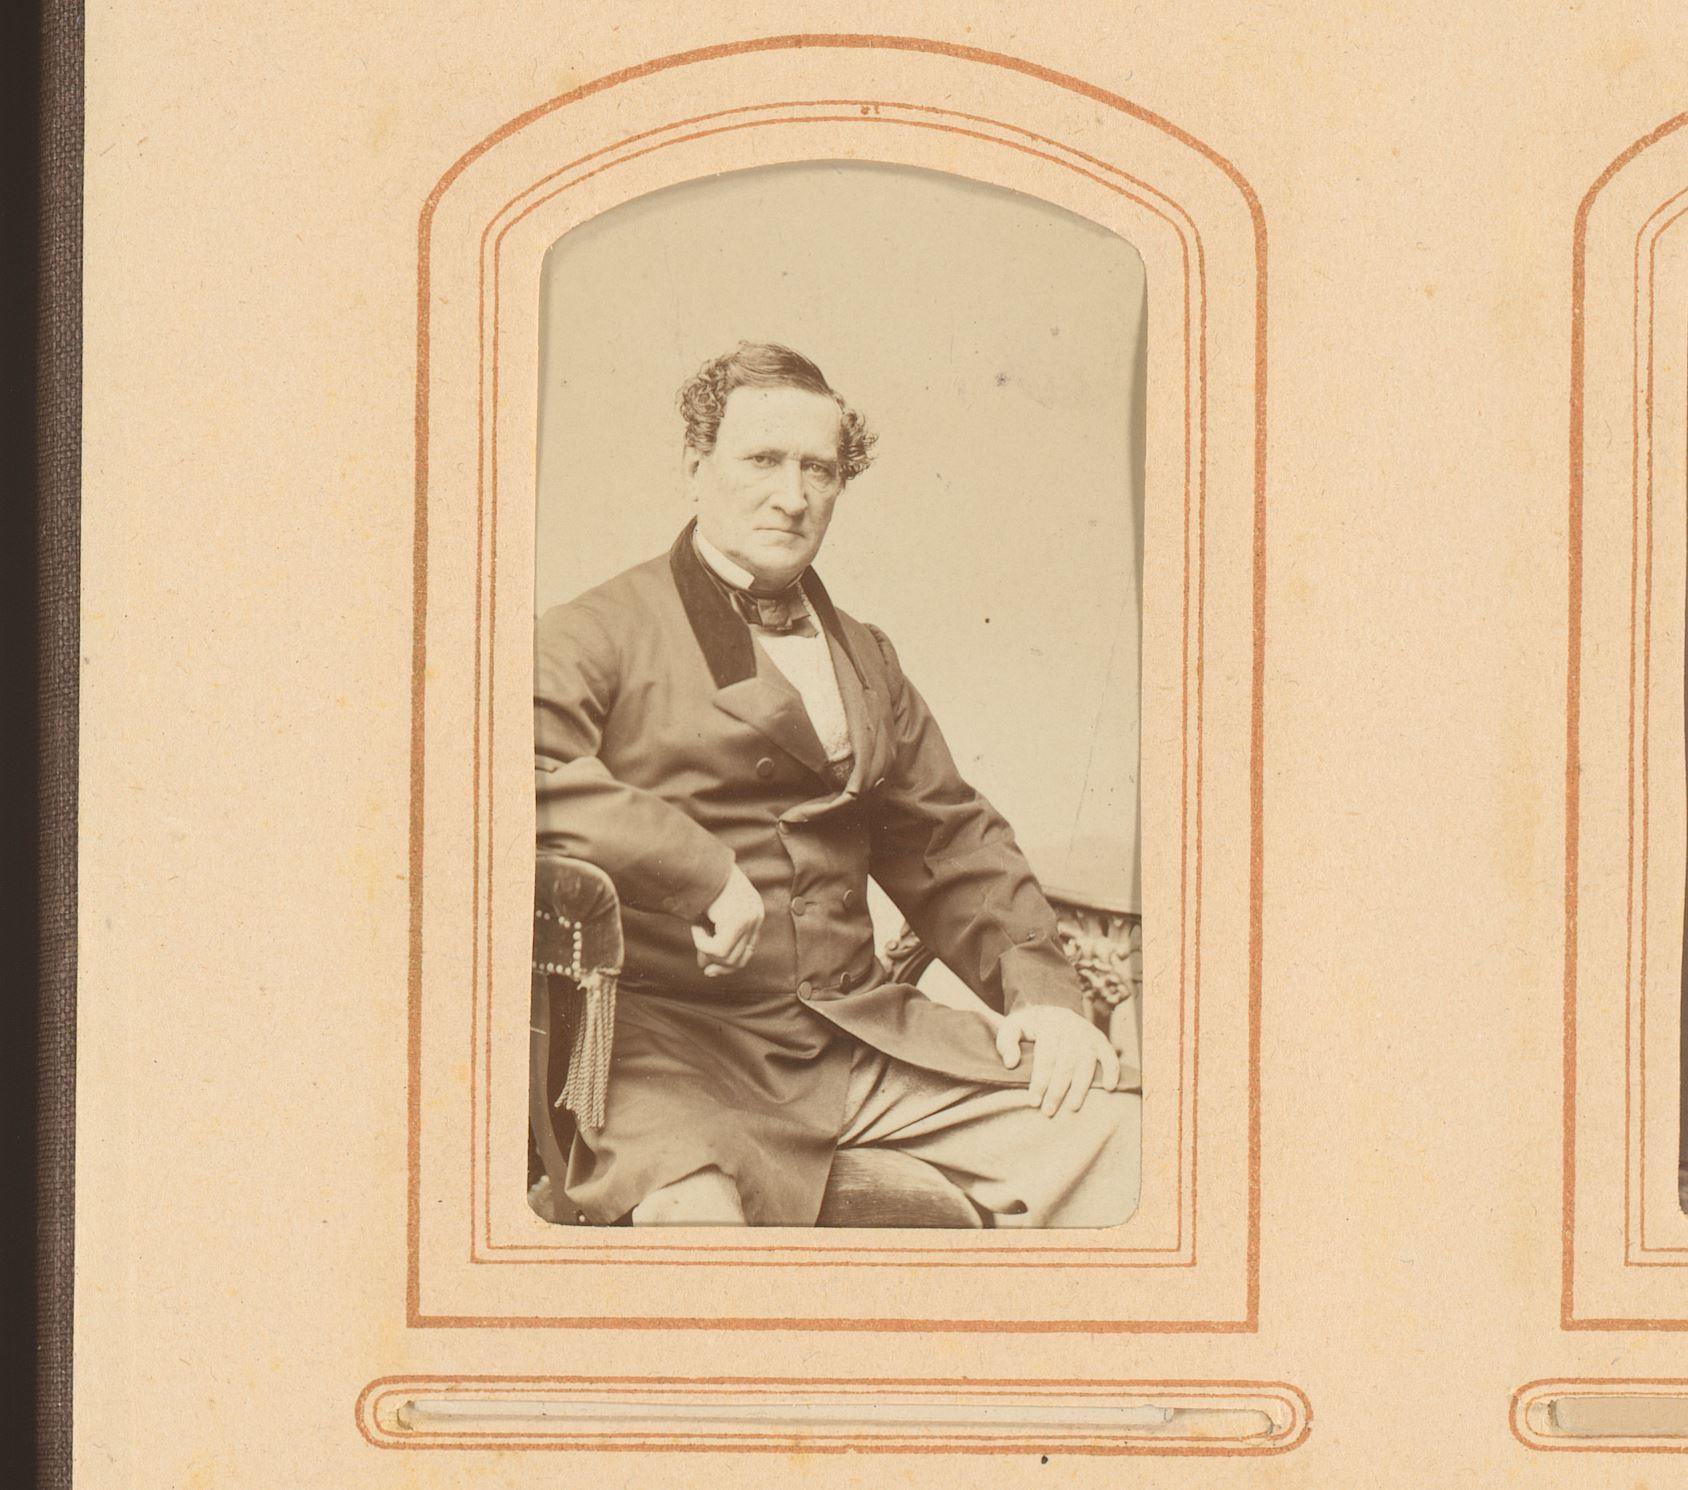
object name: photograph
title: Portret van Nils Almlöf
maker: gustav joop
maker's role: fotograaf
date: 1855-1875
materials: cardboard, photographic support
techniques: albumen print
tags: historical persons, portrait of actor, actress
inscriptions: annotation: ‘Nils Wilhelm Almlöf/ 1799-1875’, inscription: ‘Fotografi Atelier/ at/ Gust. Joop & Comp/ Stockholm/ Näckströmsgatan/ (...)’